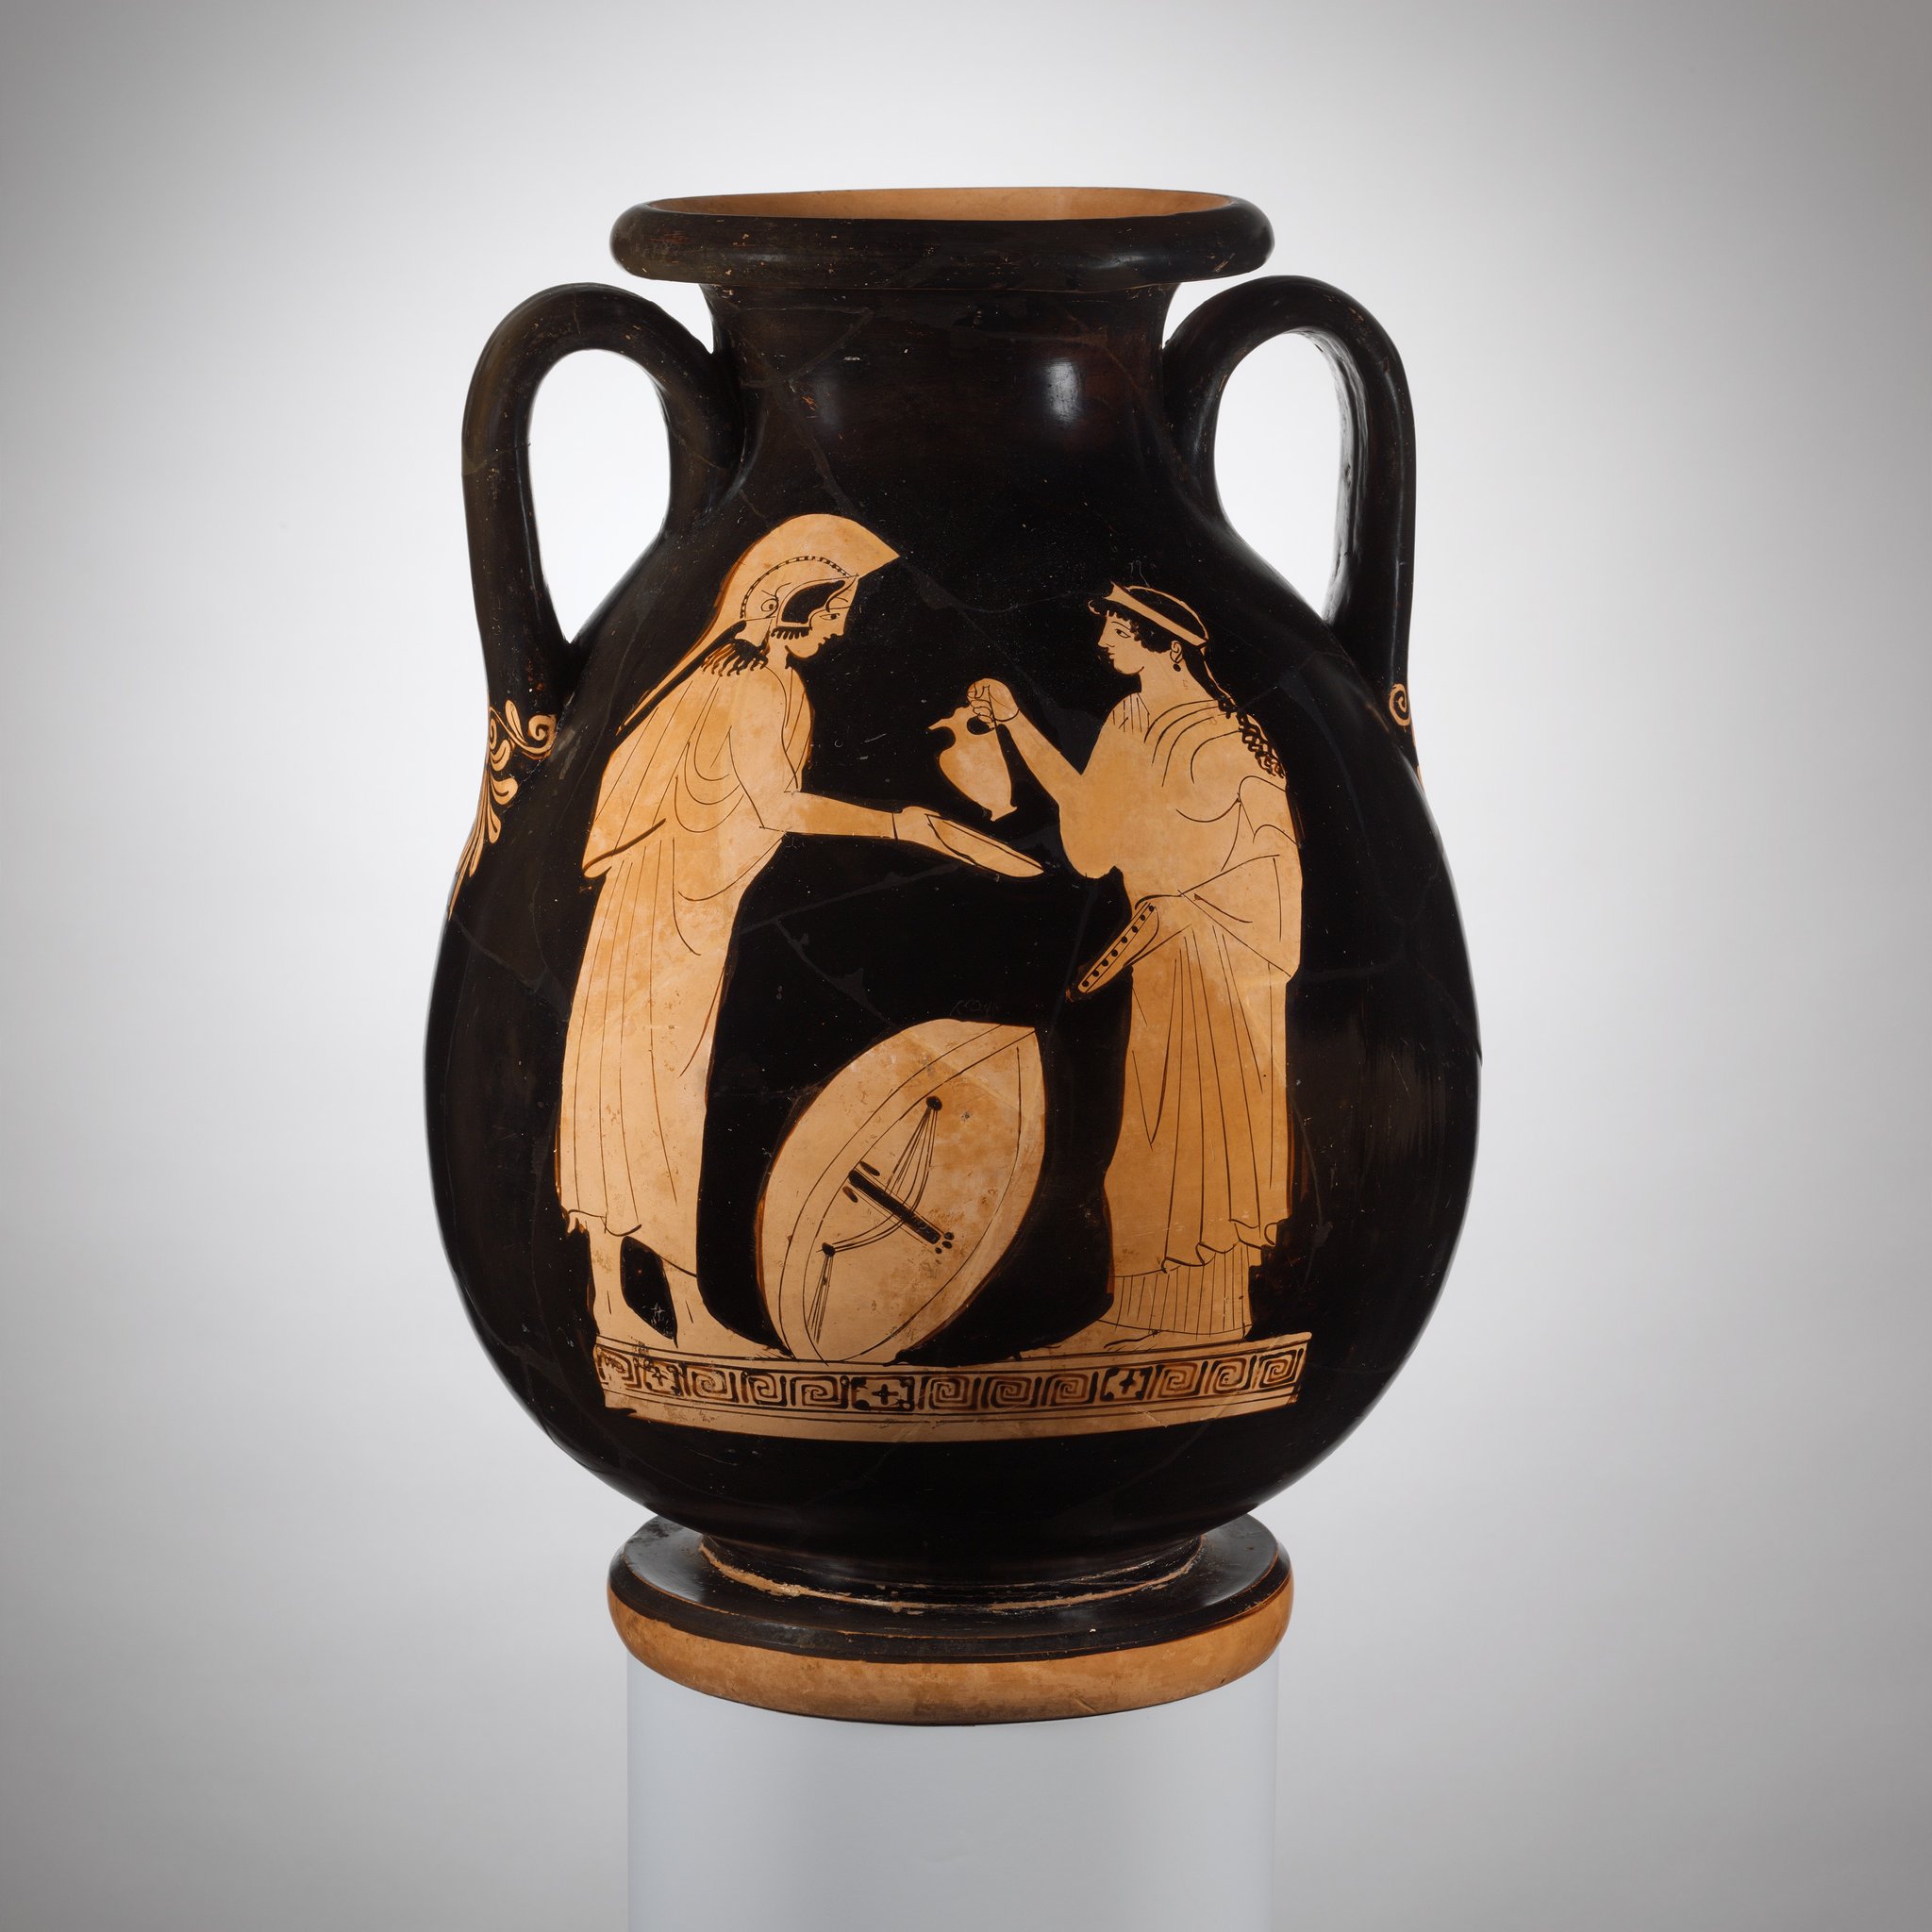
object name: pelike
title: Terracotta pelike (jar)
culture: greek, attic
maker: altamura painter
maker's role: artist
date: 470 BCE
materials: terracotta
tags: shields,men,women,warriors